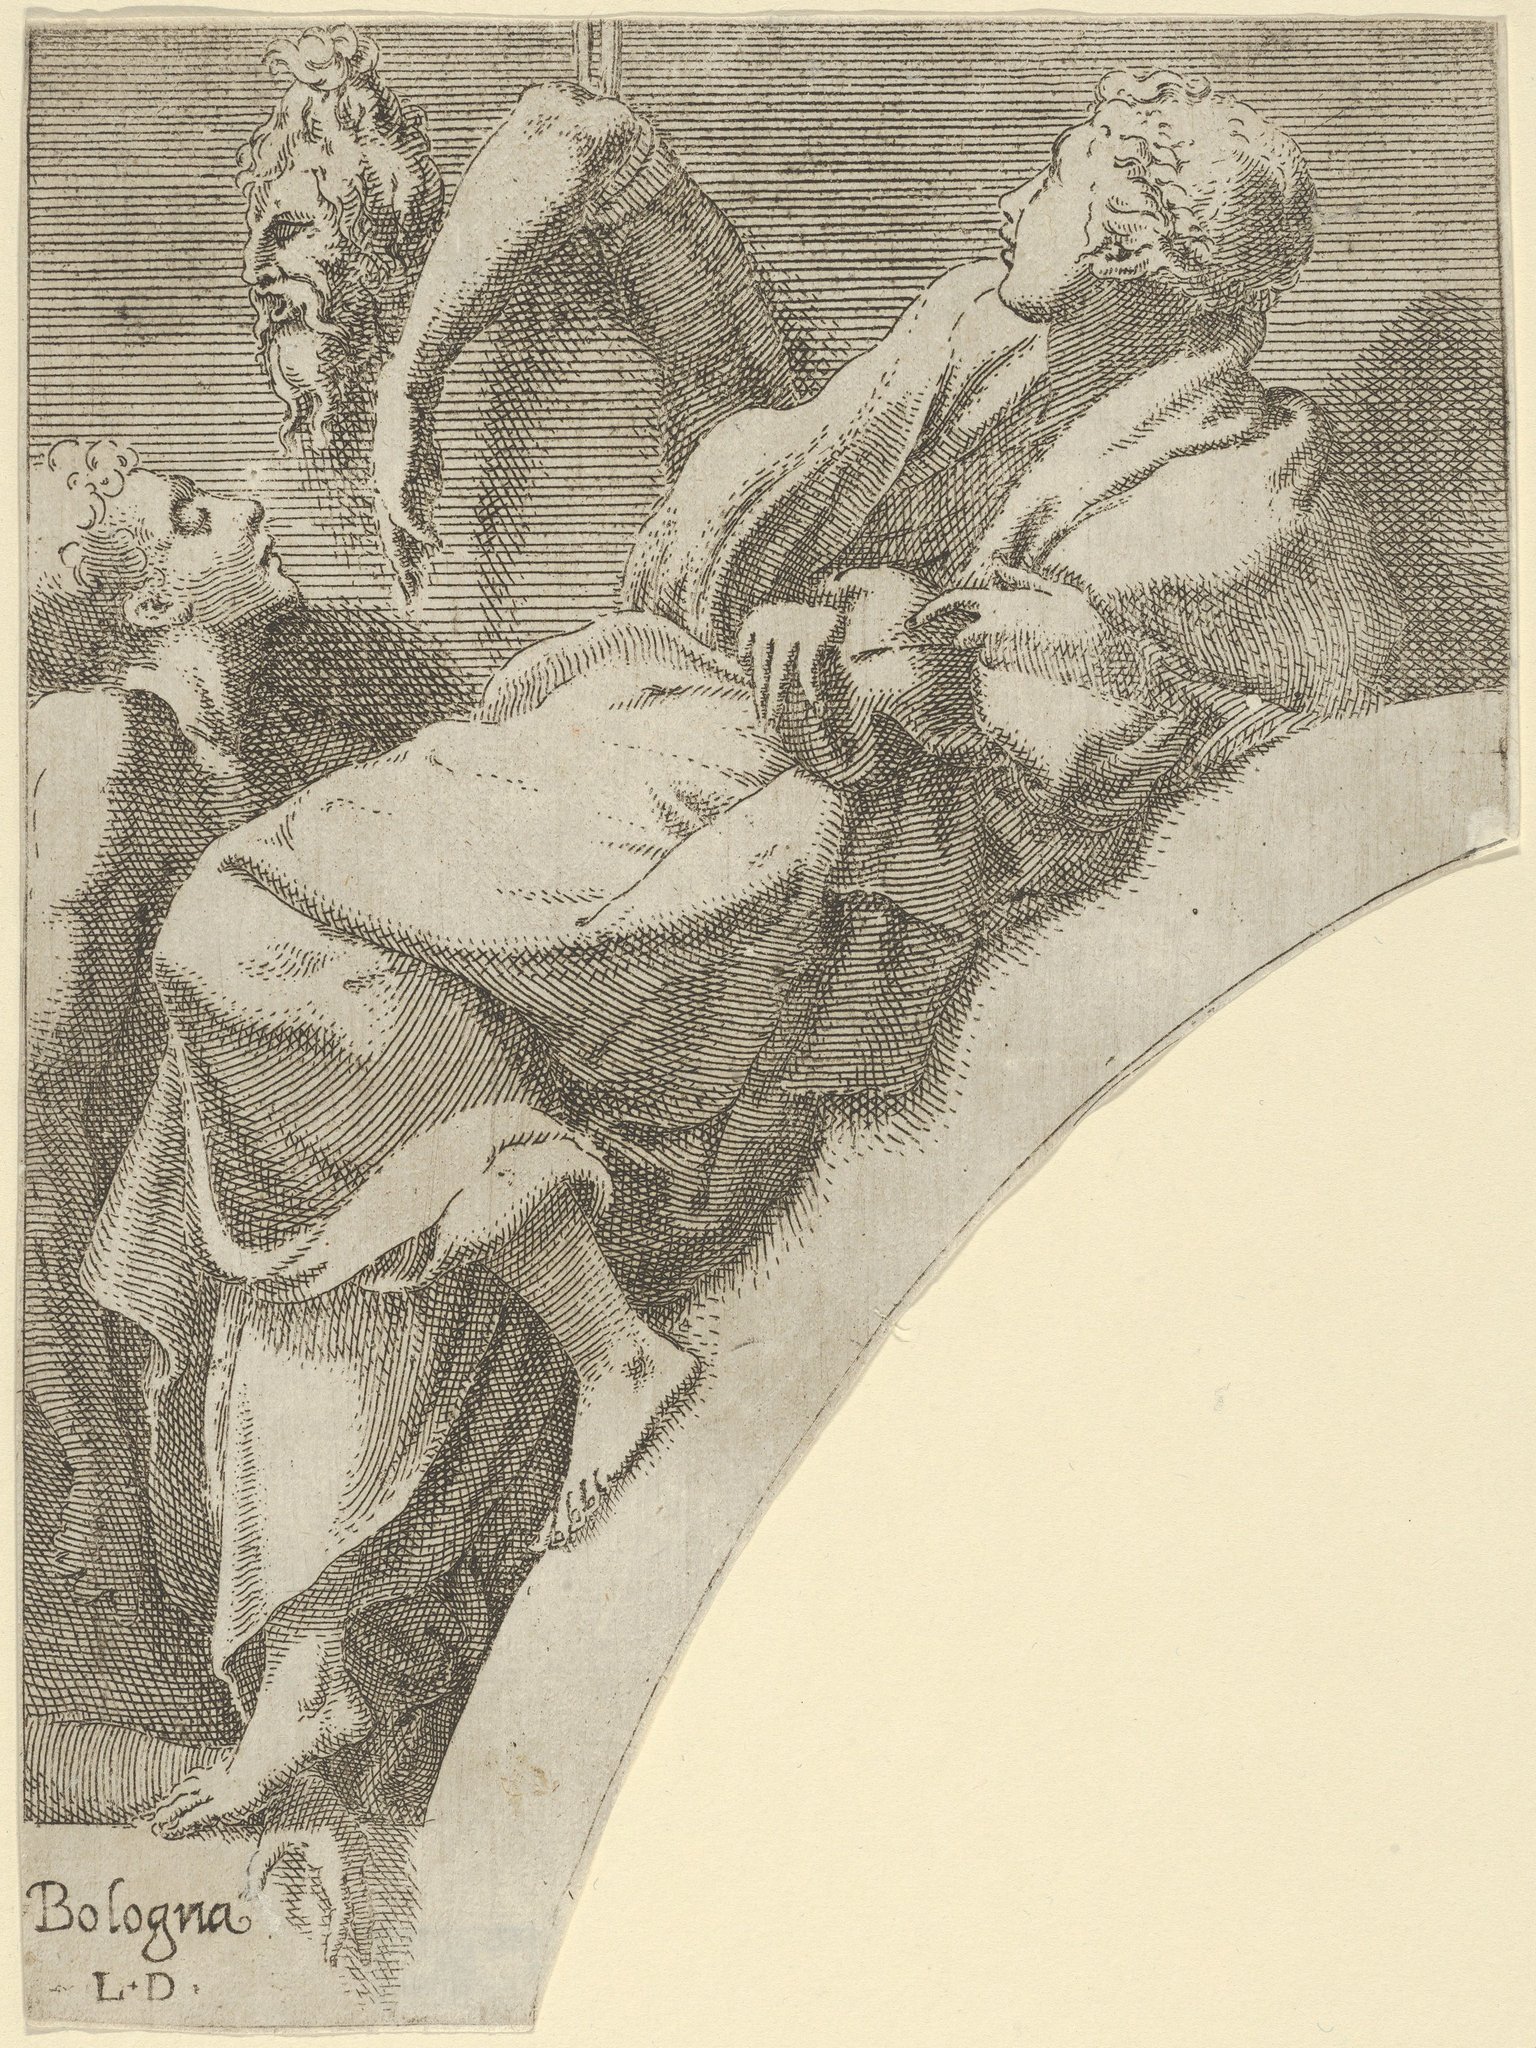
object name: print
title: Melpomene, from "Twelve Muses and Goddesses"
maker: léon davent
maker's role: artist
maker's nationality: french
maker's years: 1540-1556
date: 1540-1545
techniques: etching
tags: men,women